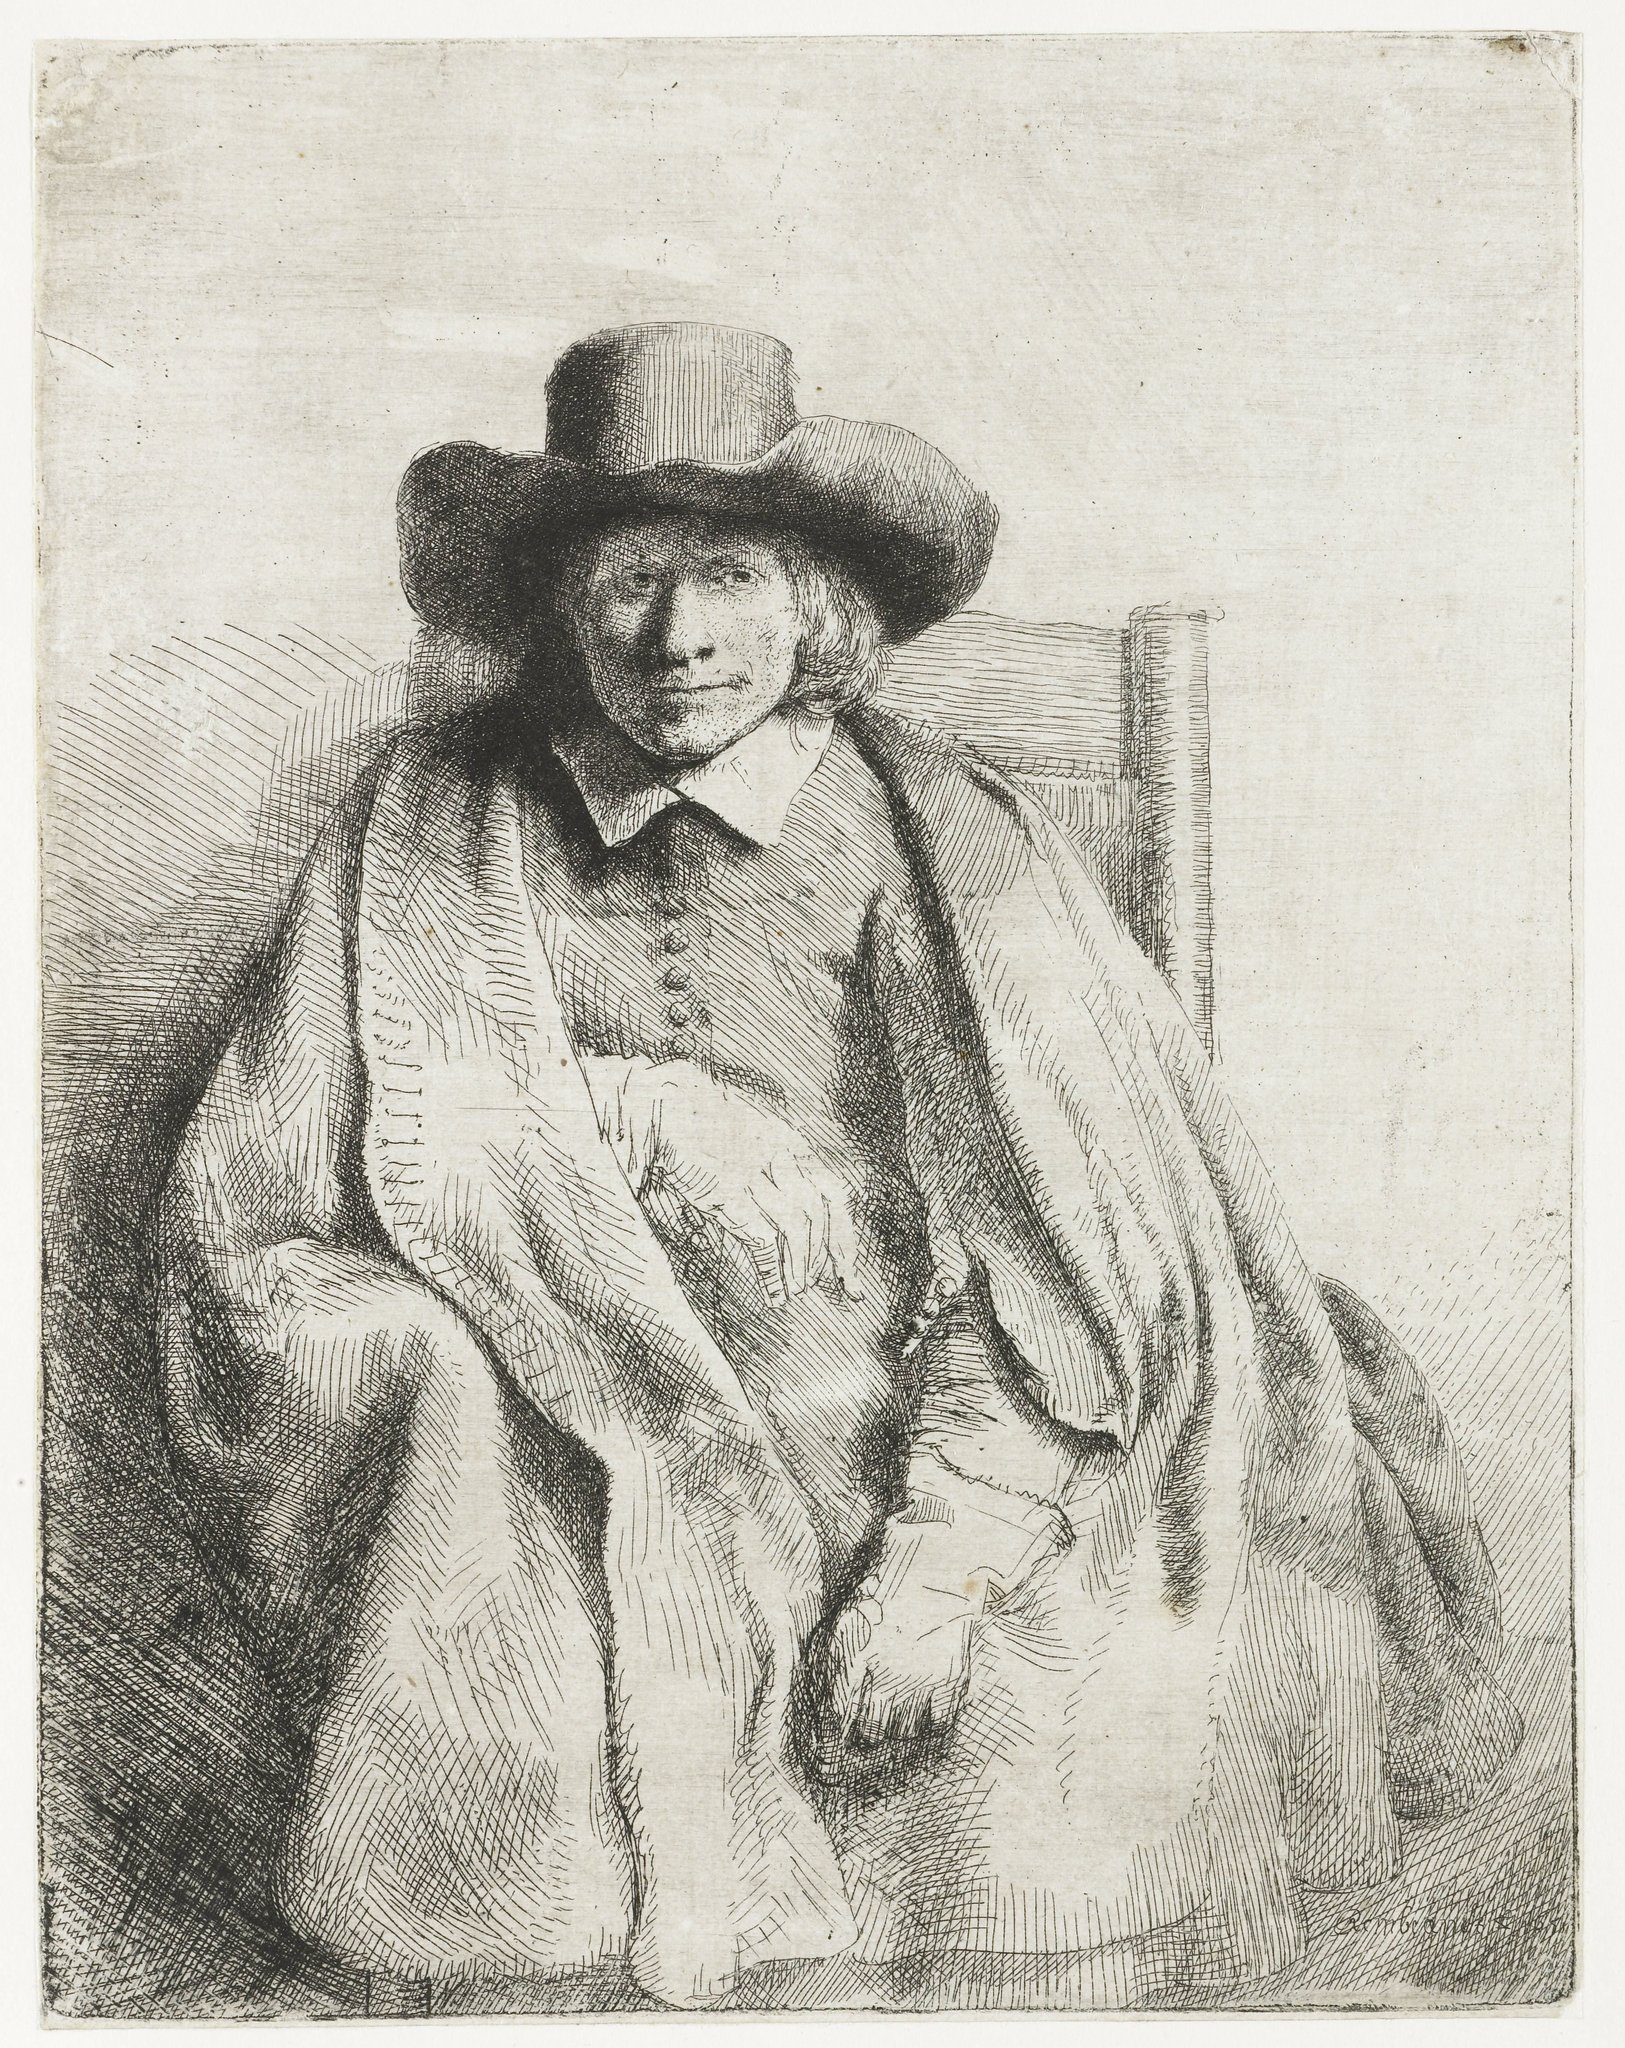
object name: print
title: Clement de Jonghe, printseller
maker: rembrandt van rijn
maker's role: draughtsman, painter, print maker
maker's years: 1606-1669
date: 1651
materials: paper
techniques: etching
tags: germany, amsterdam, print maker, publisher, clement de jonghe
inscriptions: collector's mark: Lugt 240, signature and date: ‘Rembrandt f 1651’